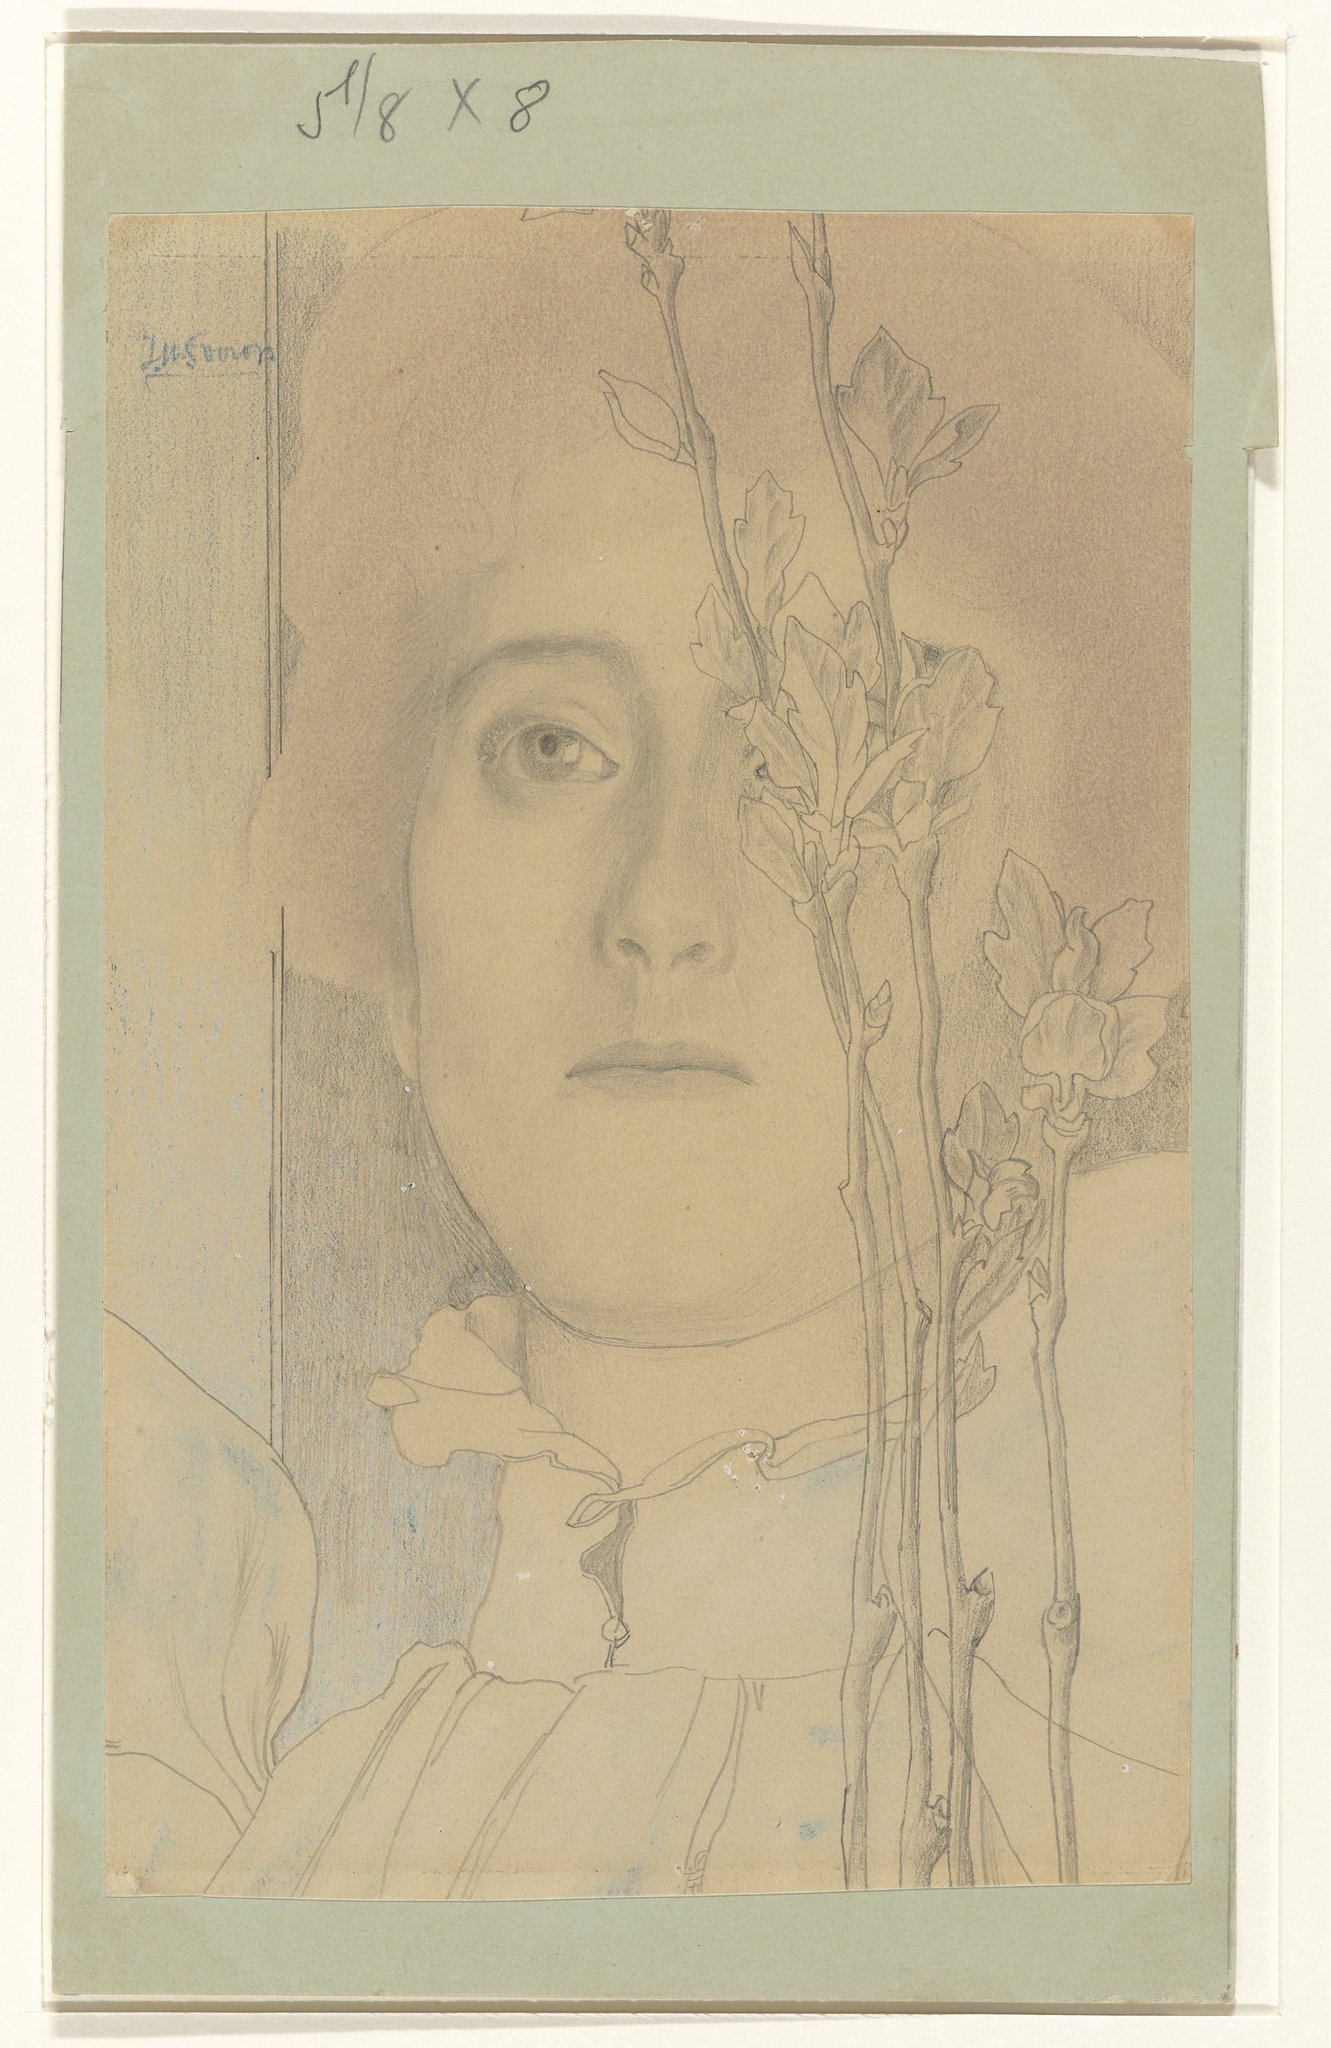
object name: drawing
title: Portret van een onbekende vrouw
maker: jan toorop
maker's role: draughtsman, painter, print maker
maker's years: 1858-1928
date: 1868-1928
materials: chalk, paper, pencil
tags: historical persons (portraits and scenes from the life)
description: Portret van een onbekende vrouw, haar linker gezichtshelft gaat schuil achter uitbottende takjes.